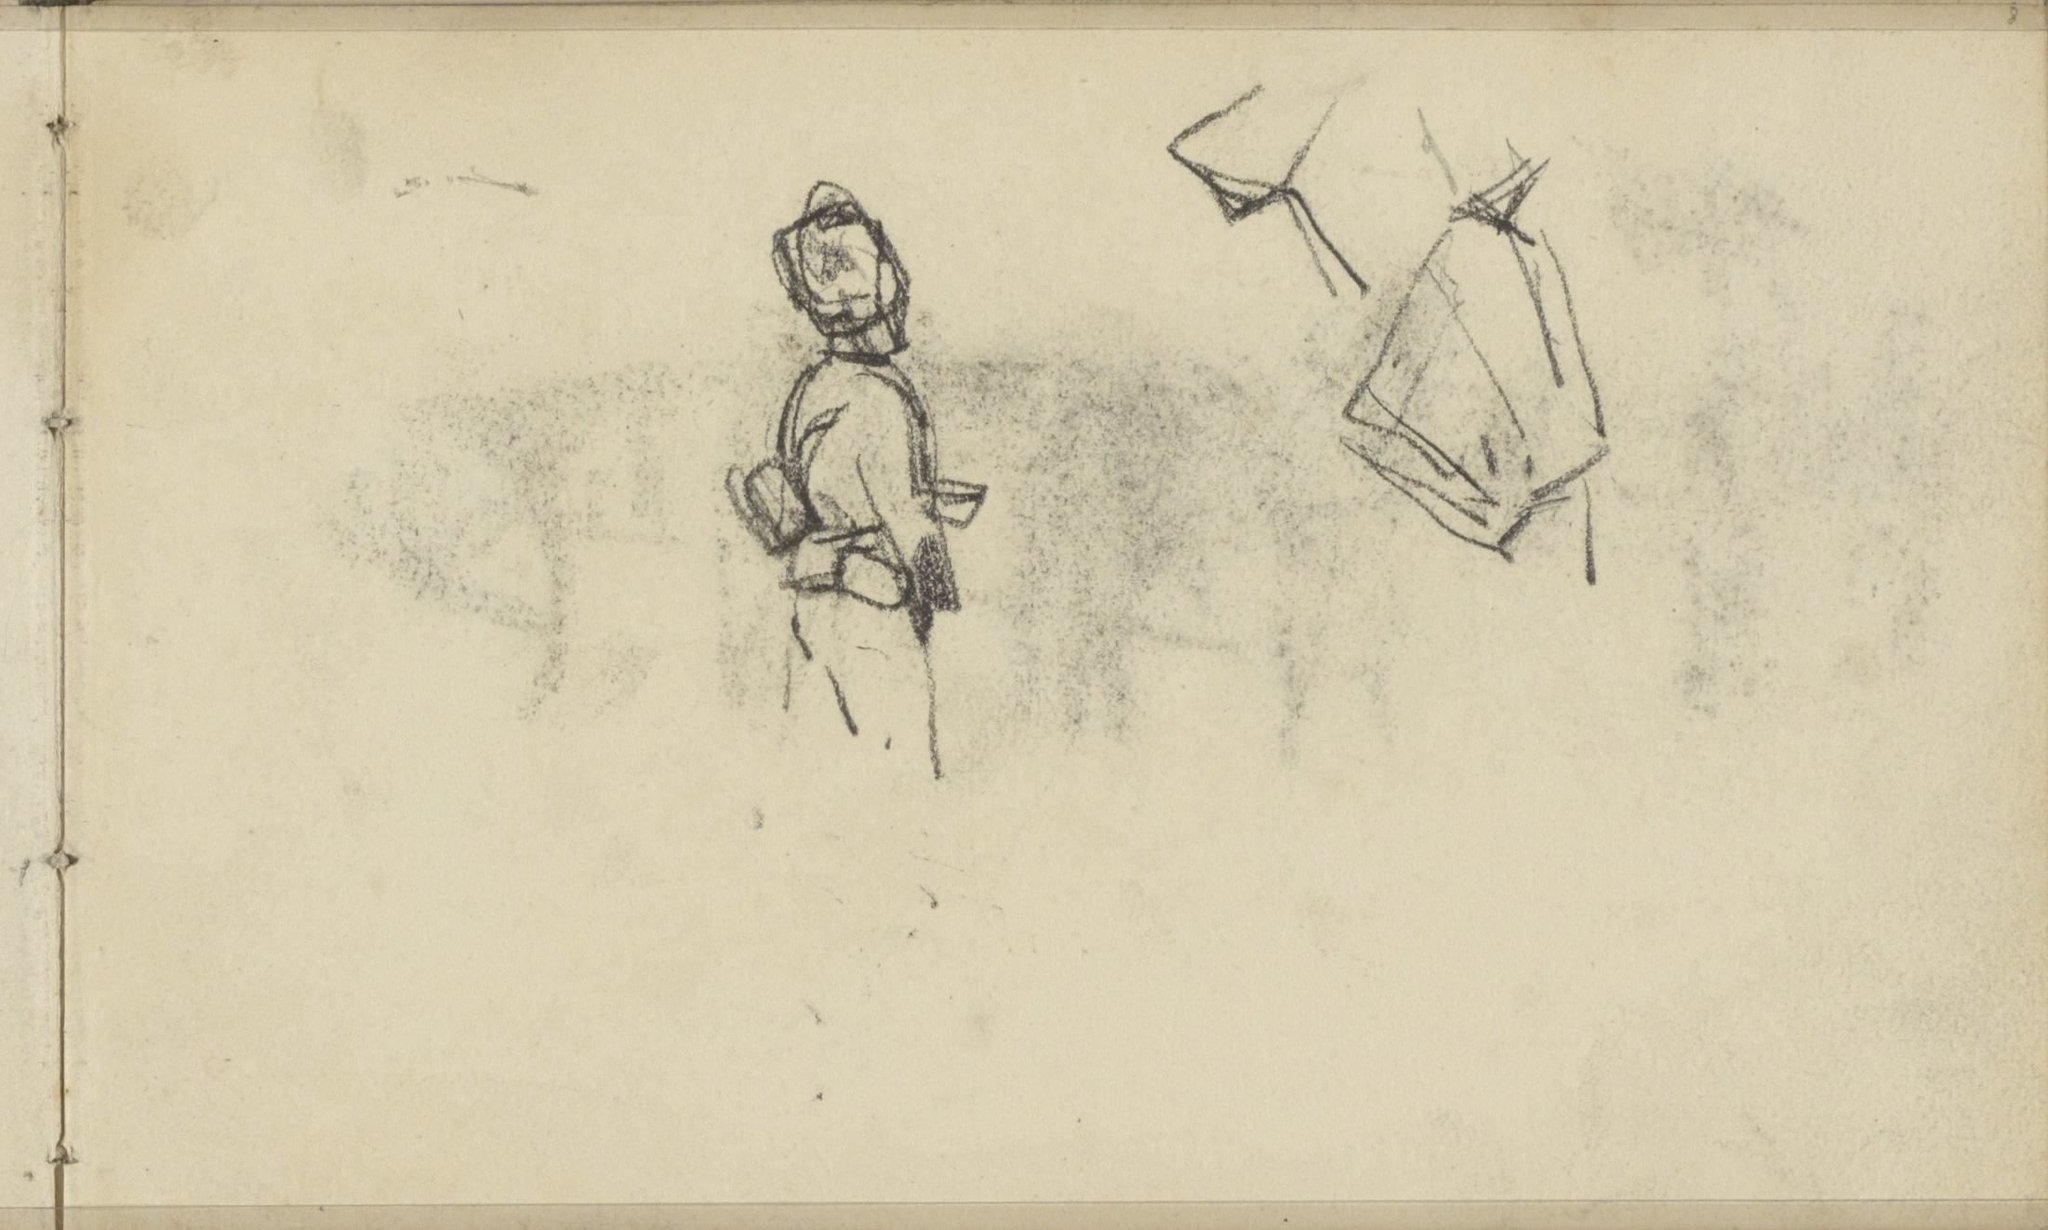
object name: sketchbook leaf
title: Soldaat, mogelijk een artillerist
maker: george hendrik breitner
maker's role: draughtsman, painter, print maker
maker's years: 1857-1923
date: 1884-1886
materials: chalk, paper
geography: the hague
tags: land forces (+ artillery)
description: Pagina 8 uit een schetsboek met 35 bladen.